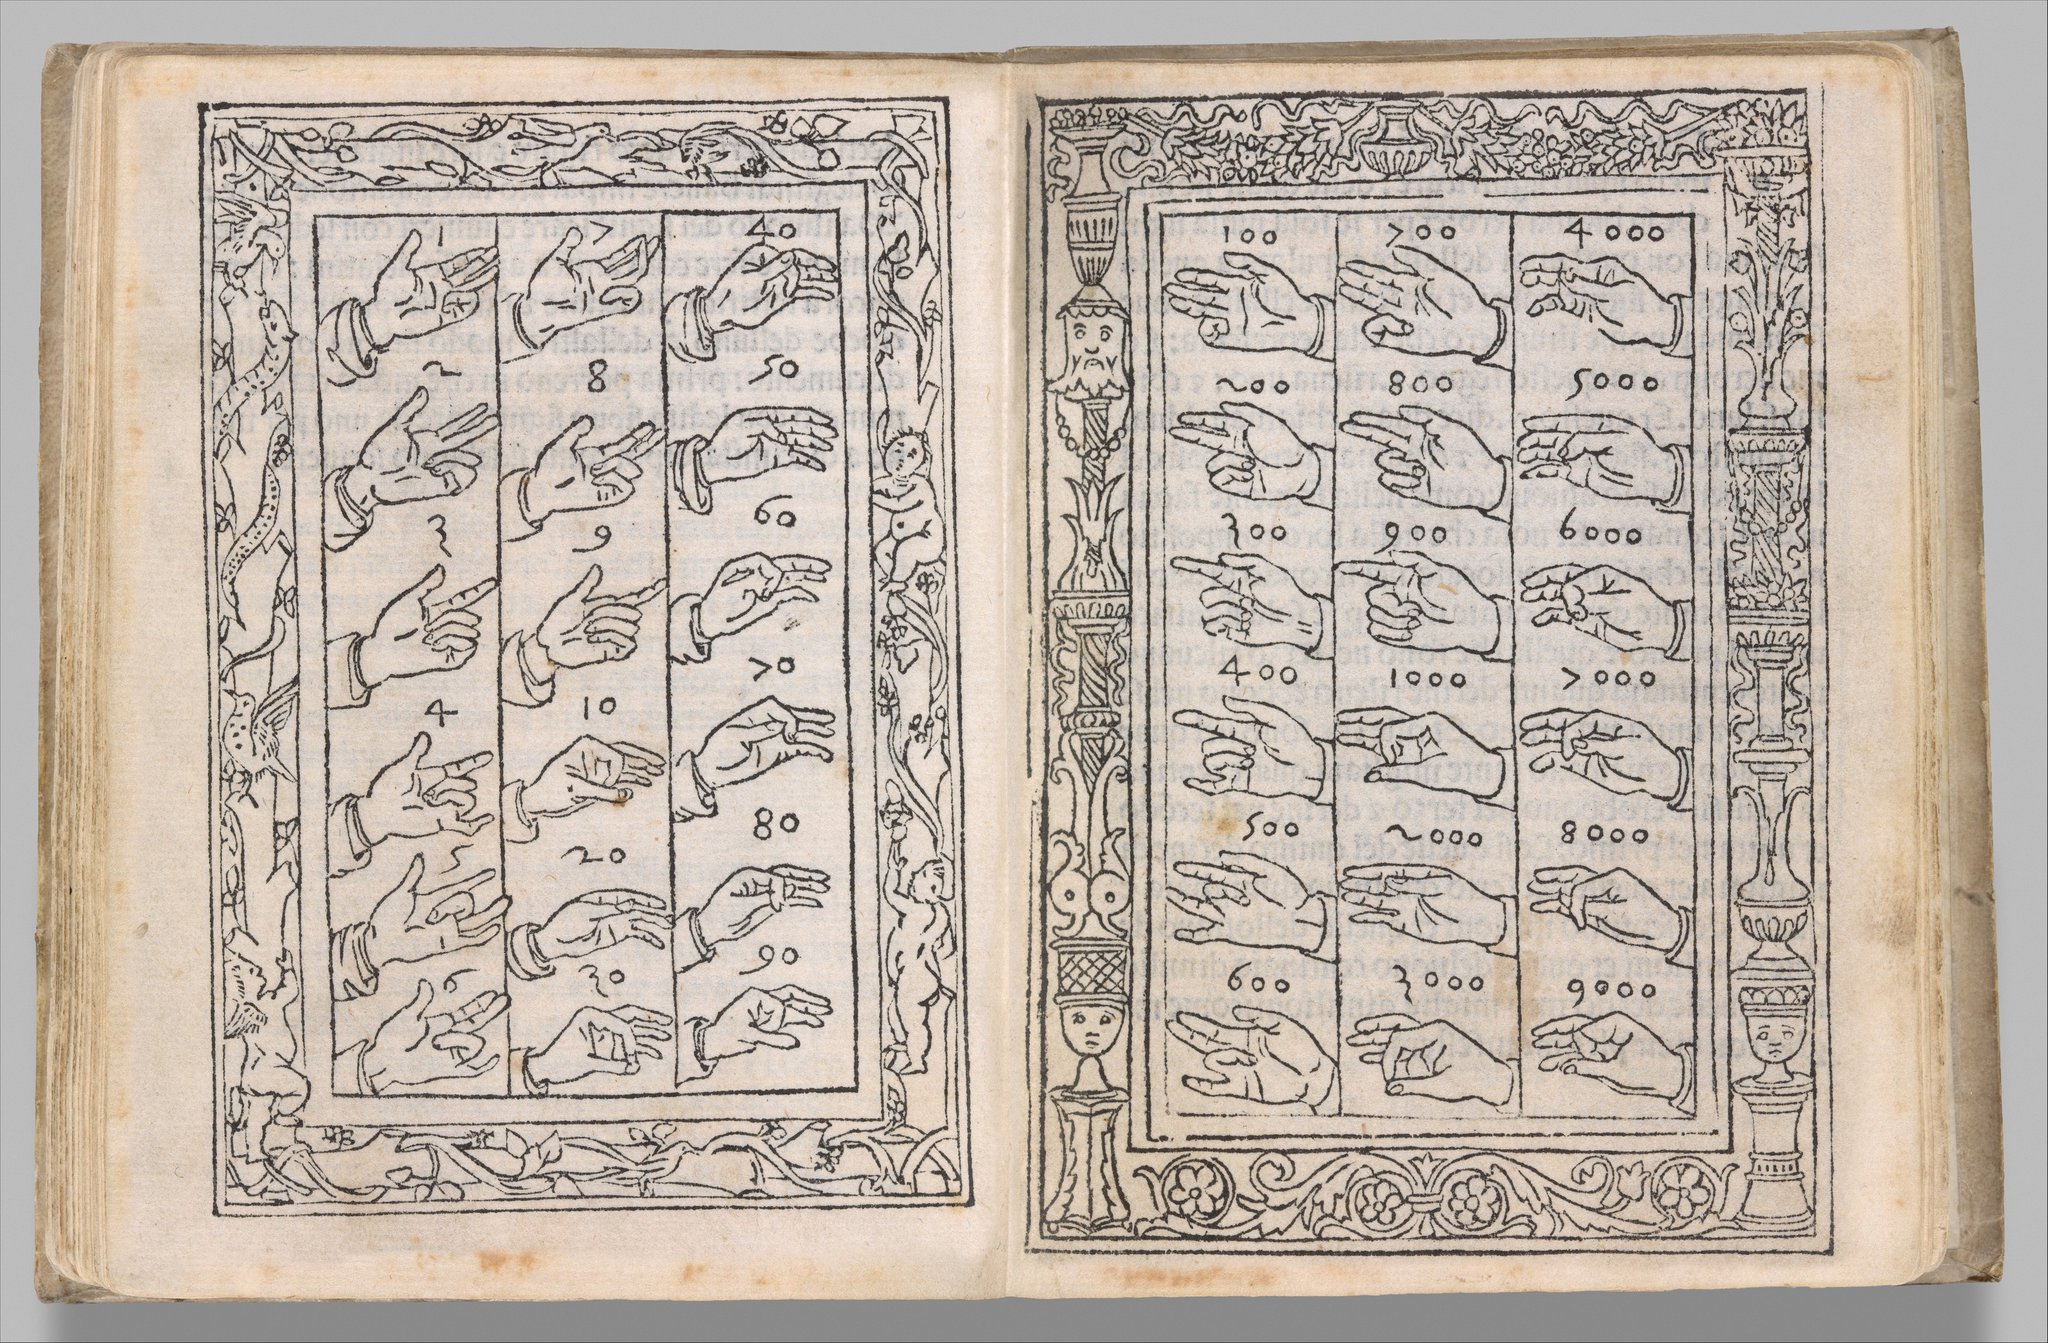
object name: book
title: De Arithmetica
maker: filippo calandri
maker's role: author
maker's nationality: italian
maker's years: 1400-1500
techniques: printing, woodcut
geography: italy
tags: hands,mathematics